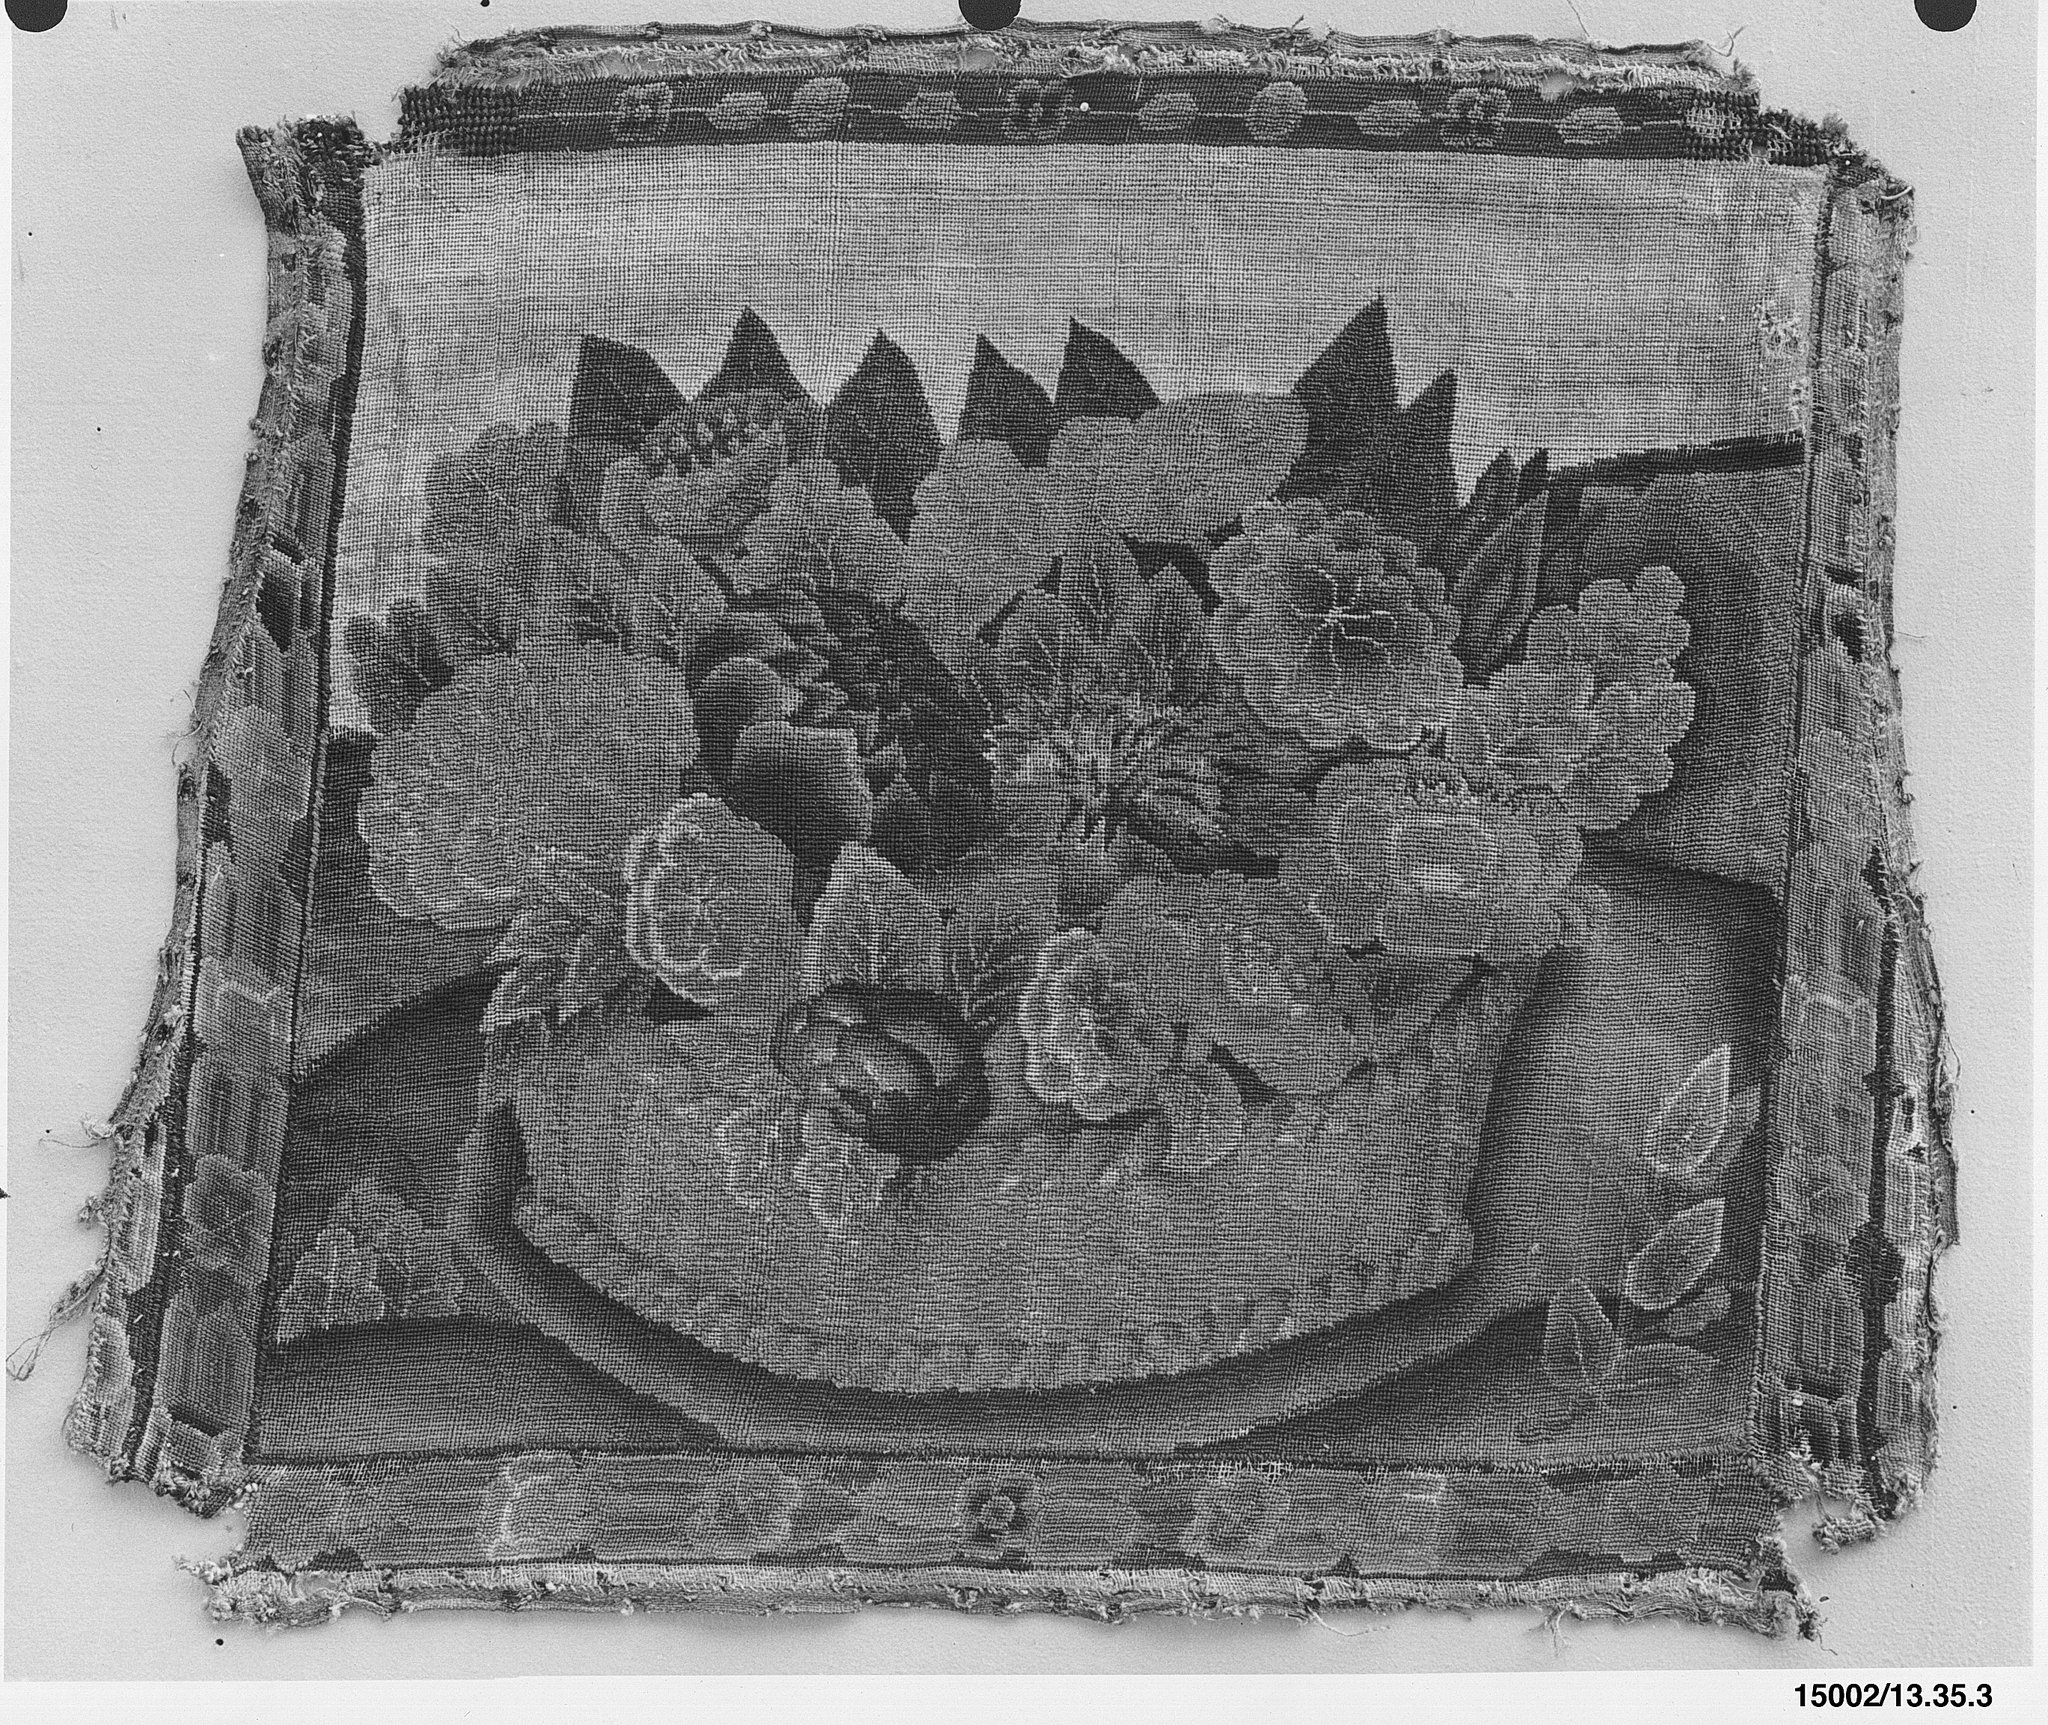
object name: cover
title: Chair seat cover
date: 1701-1800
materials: silk, wool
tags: flowers